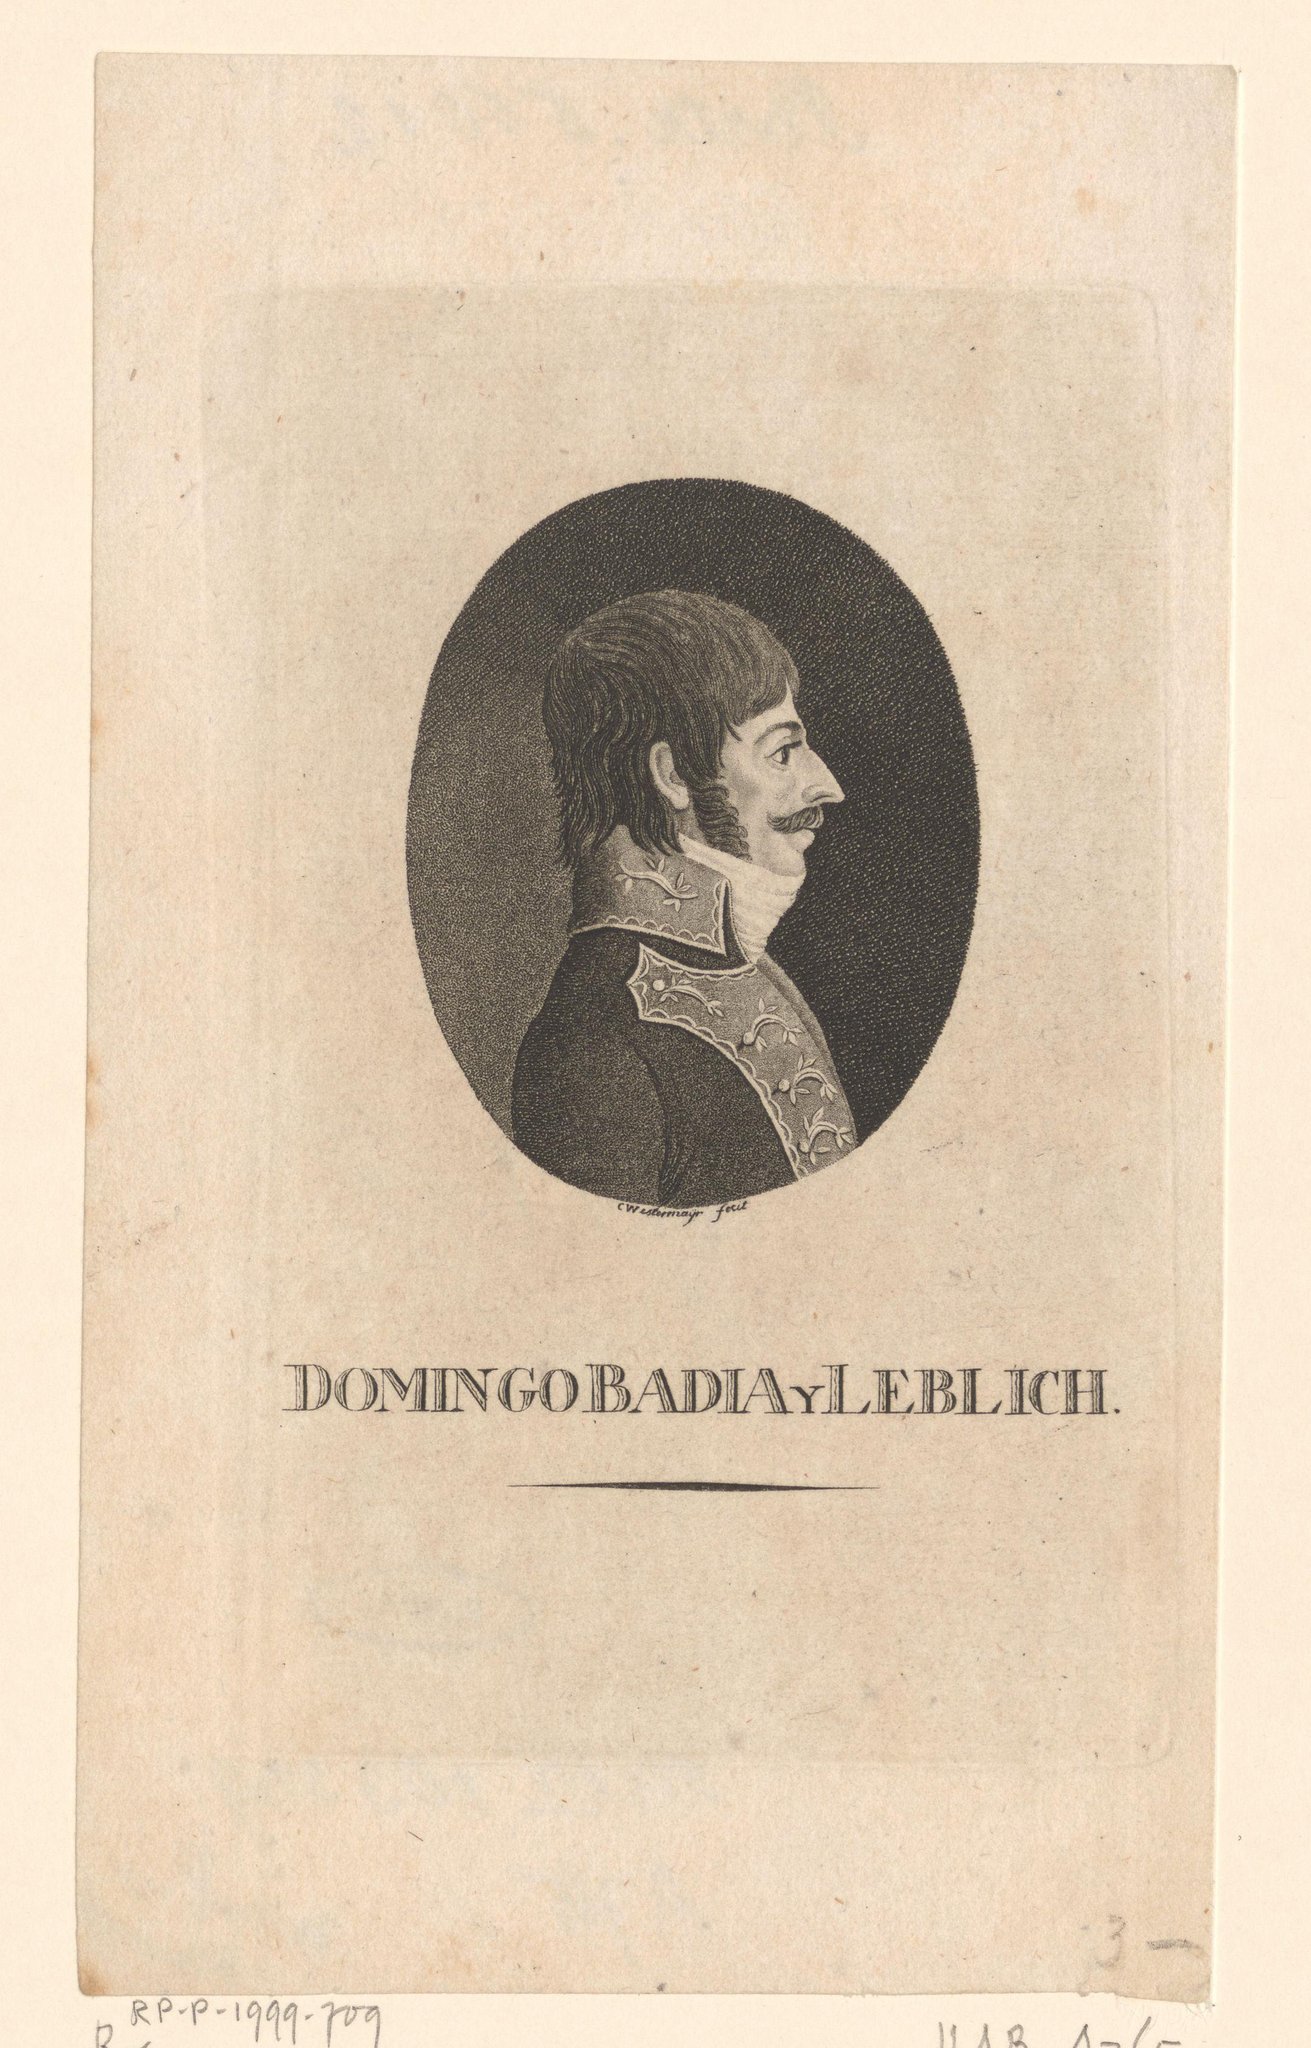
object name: print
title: Portret van Domingo Francisco Jorge Badia y Leblich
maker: konrad westermayr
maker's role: print maker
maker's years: 1765-1834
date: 1775-1834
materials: paper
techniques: etching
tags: historical persons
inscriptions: collector's mark: Lugt 2228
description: Domingo Francisco Jorge Badía y Leblich is ook bekend onder zijn pseudoniem Ali Bey el Abbassi.